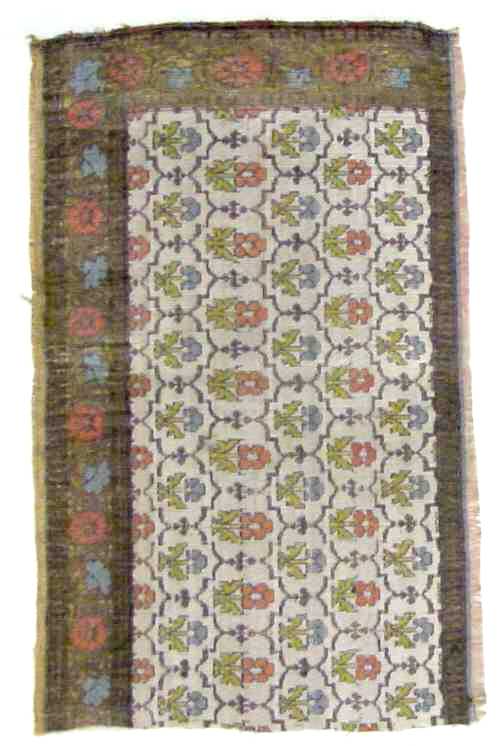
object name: textile fragment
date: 1601-1700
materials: metal thread, silk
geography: iran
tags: flowers,leaves